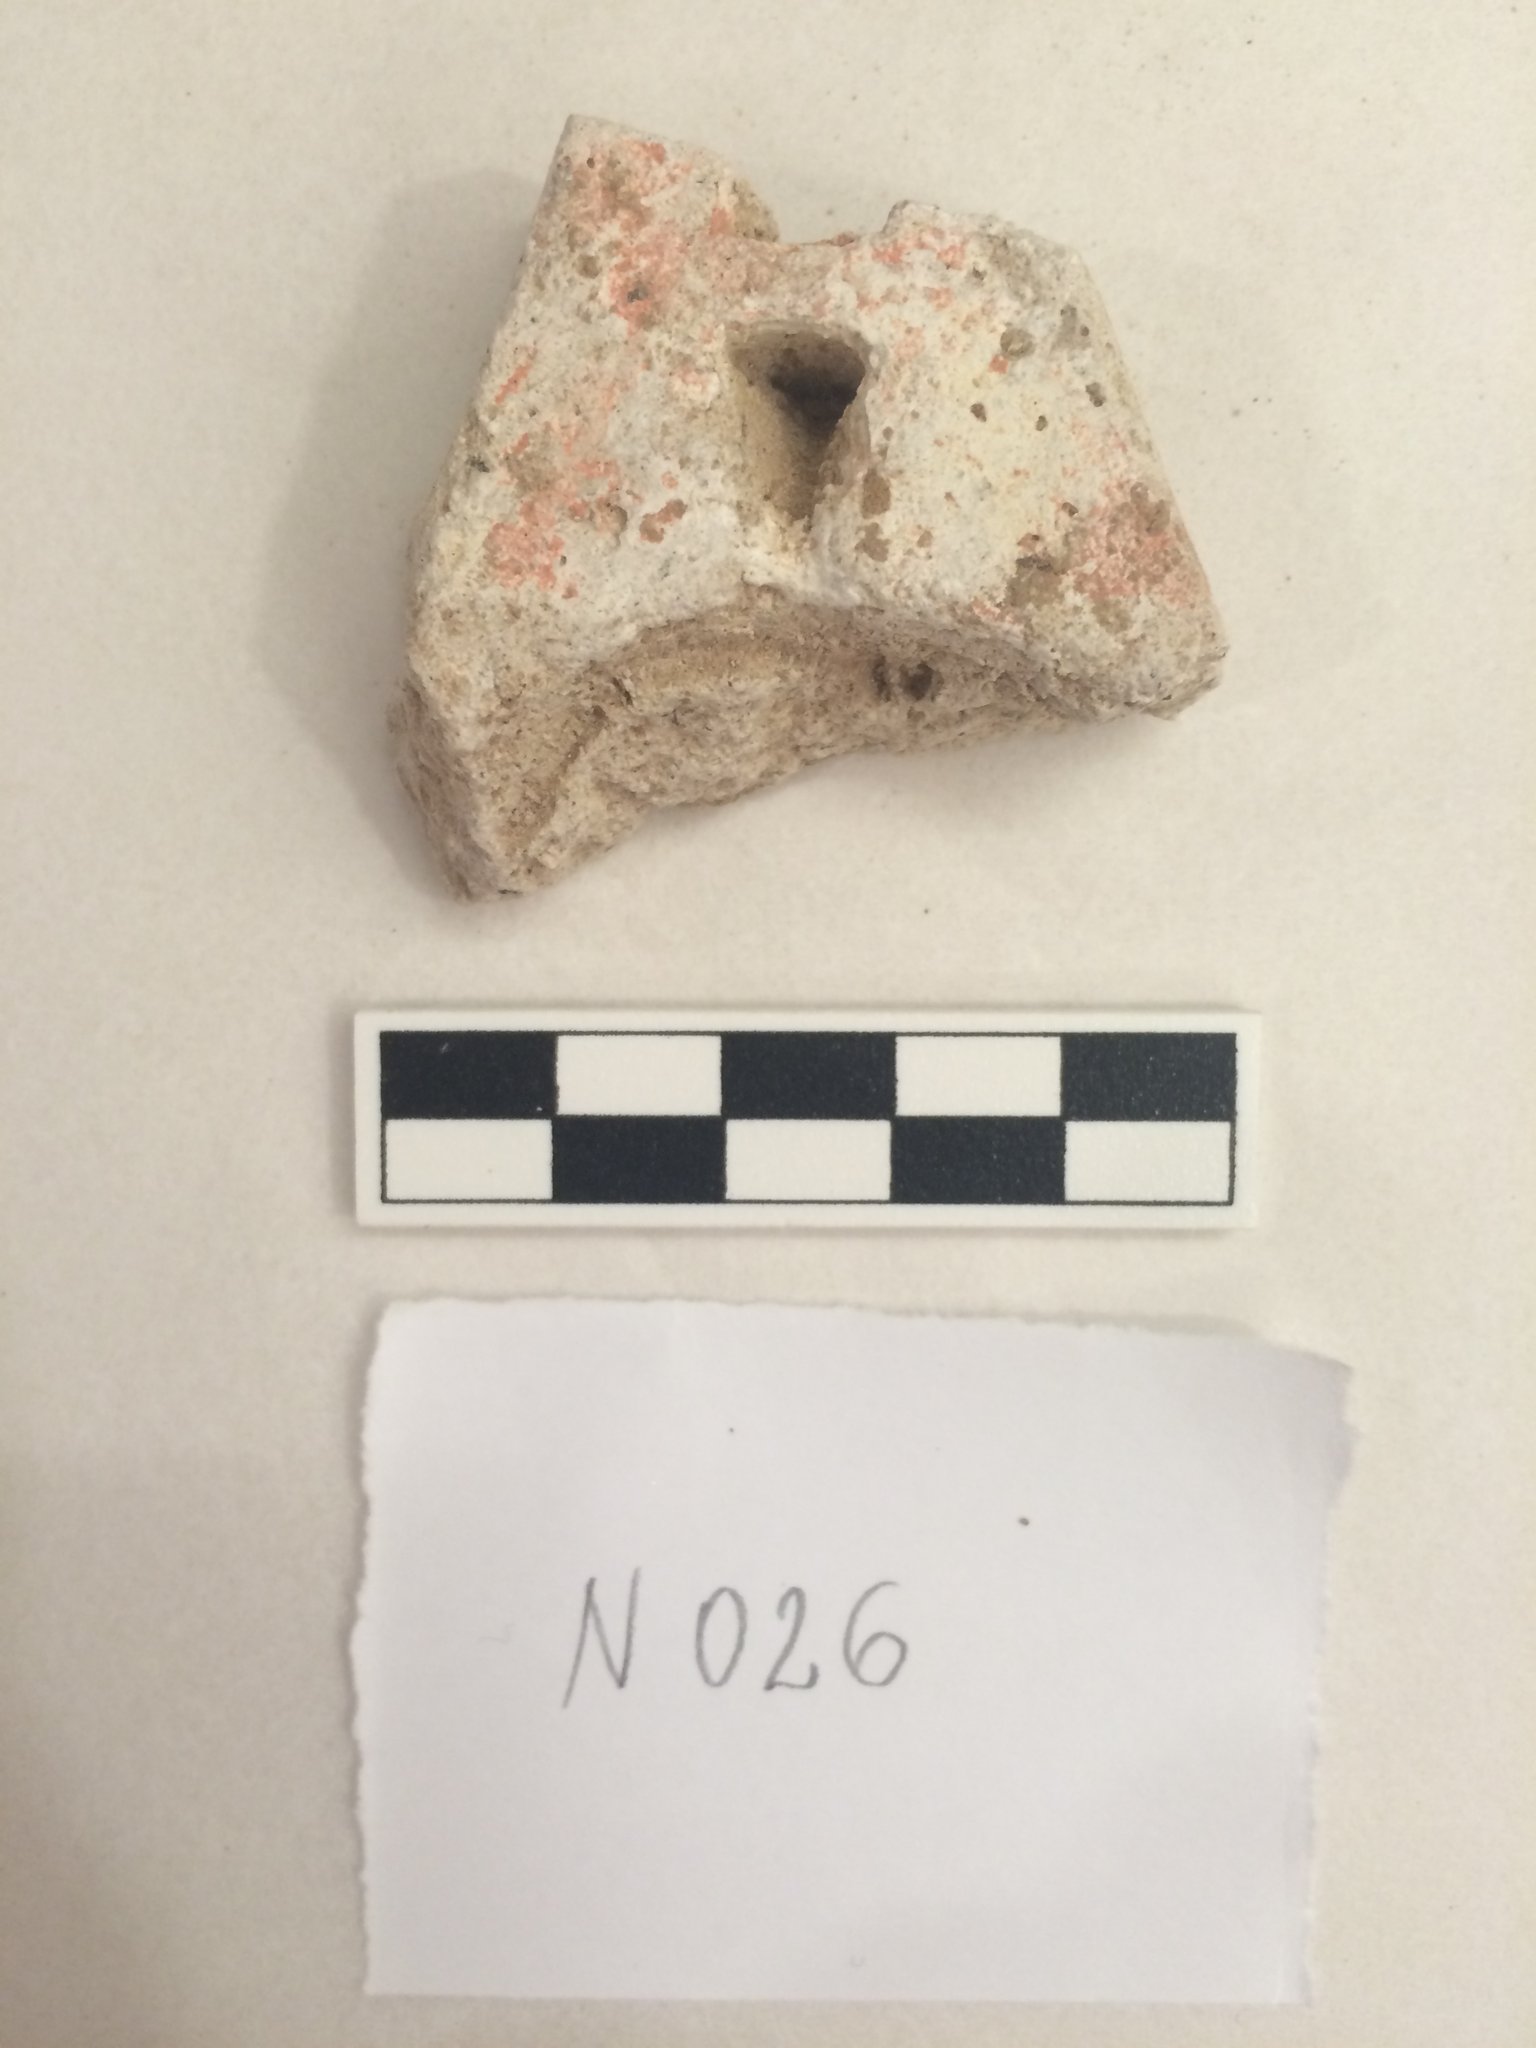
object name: fragment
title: Stucco Fragment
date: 701-1200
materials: plaster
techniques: carving, painting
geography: iran